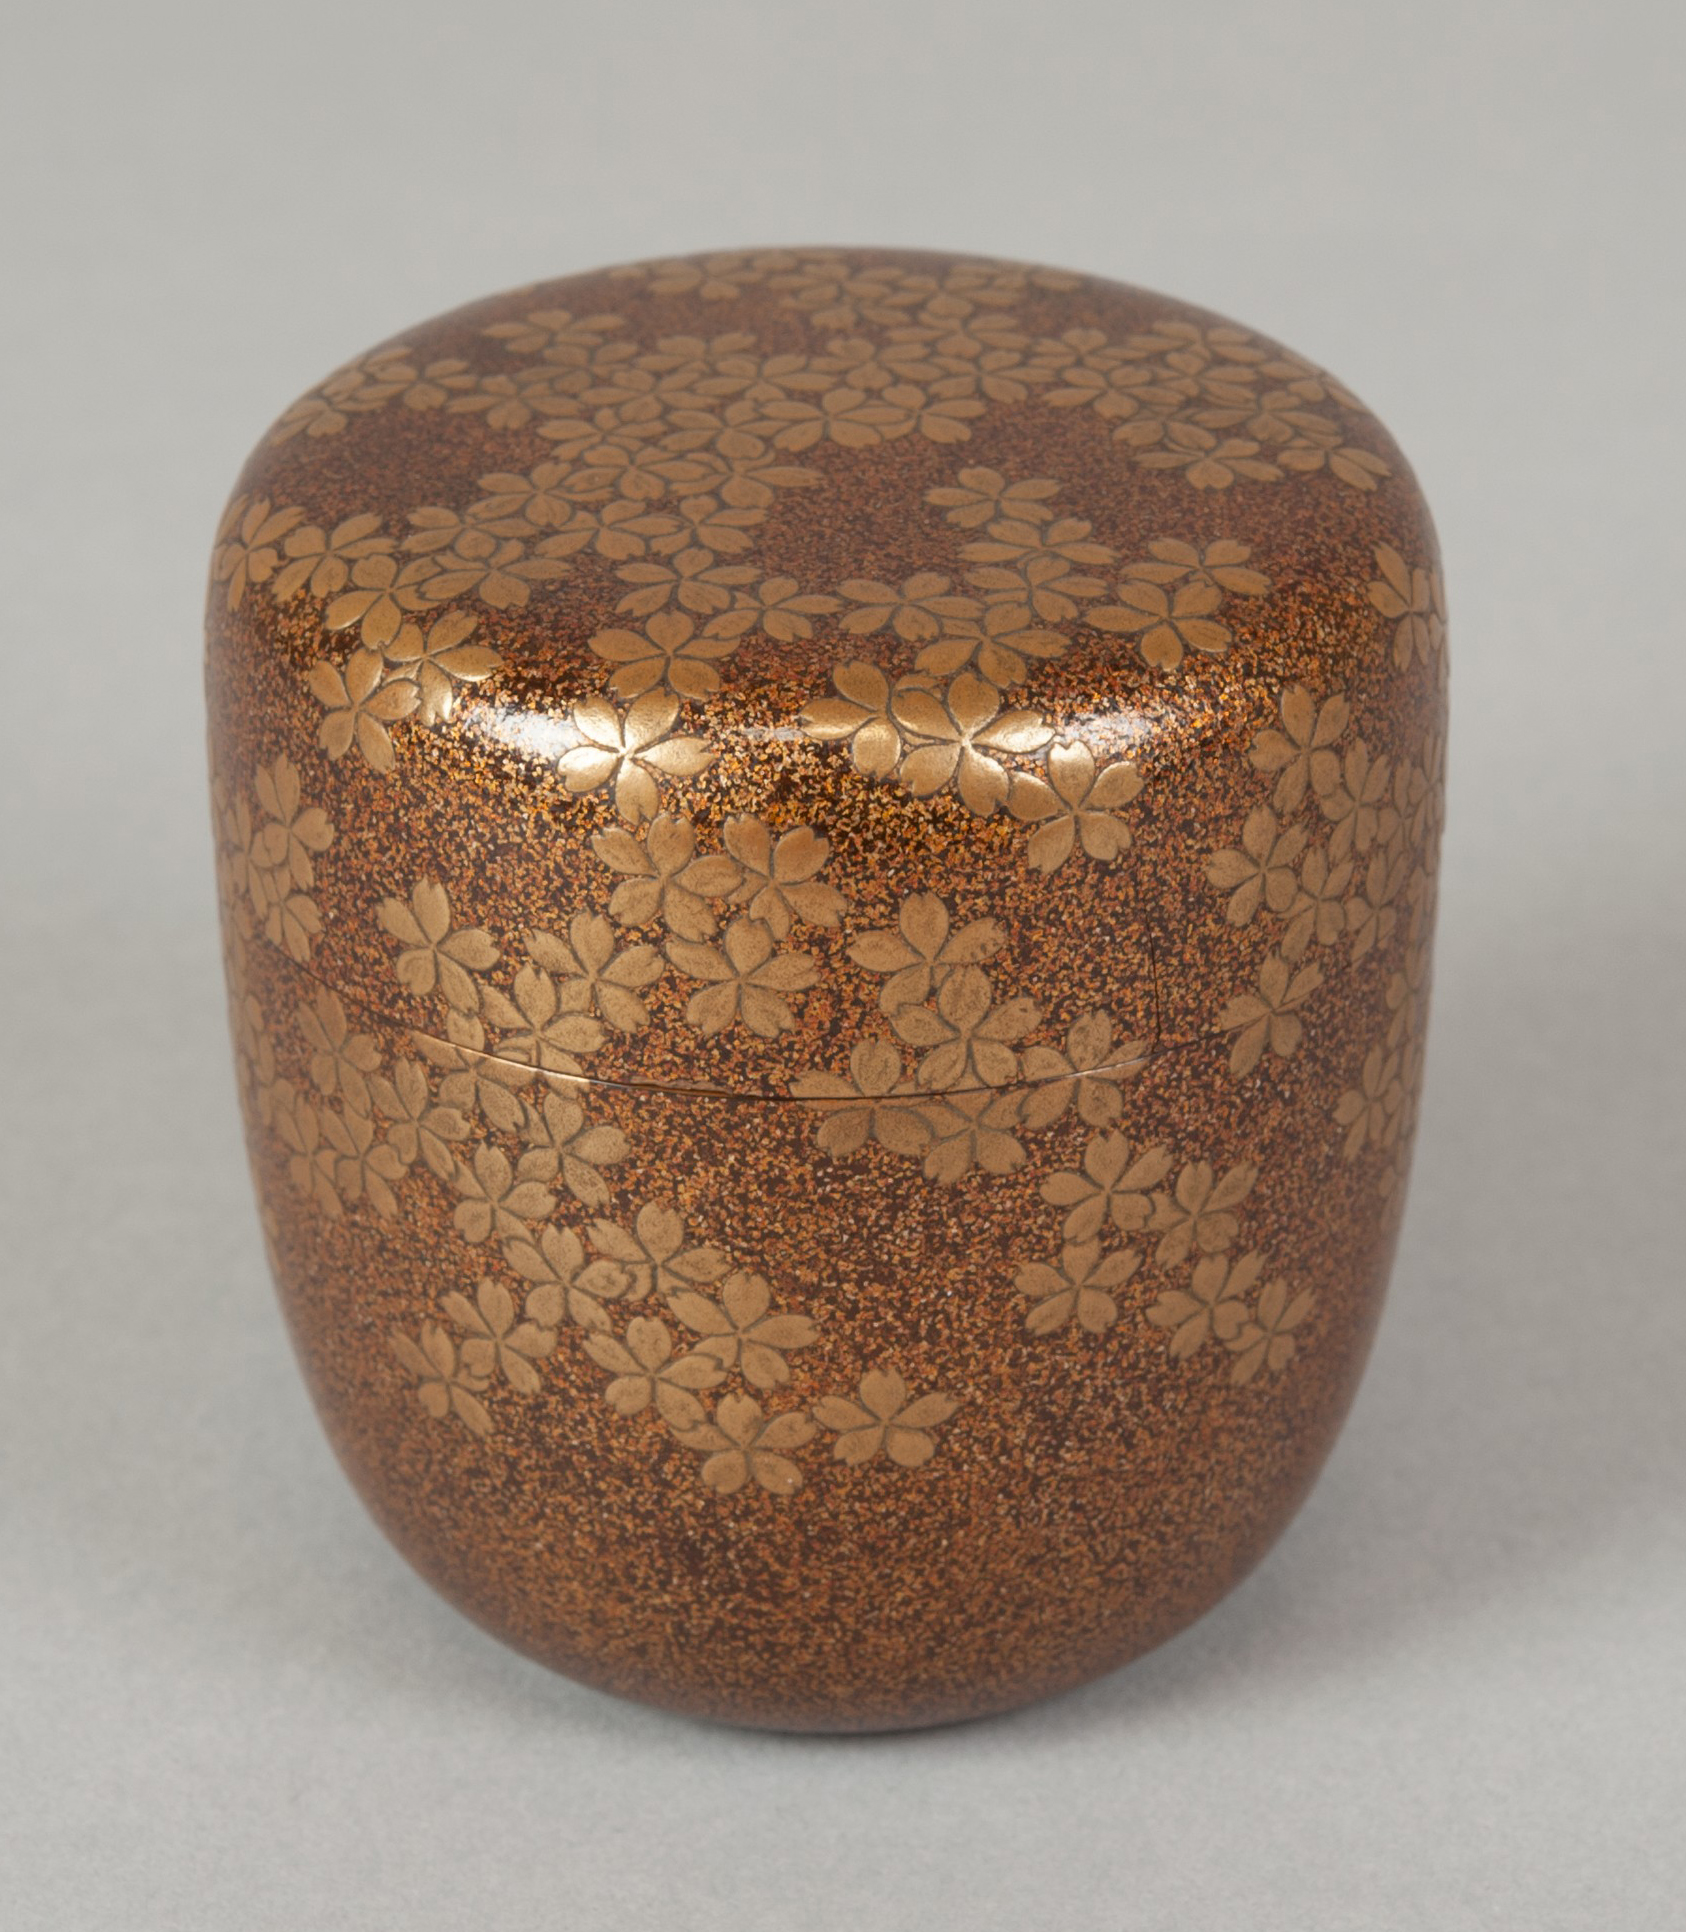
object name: tea caddy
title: Tea Caddy with Cover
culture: japanese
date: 1767-1800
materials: gold, lacquer